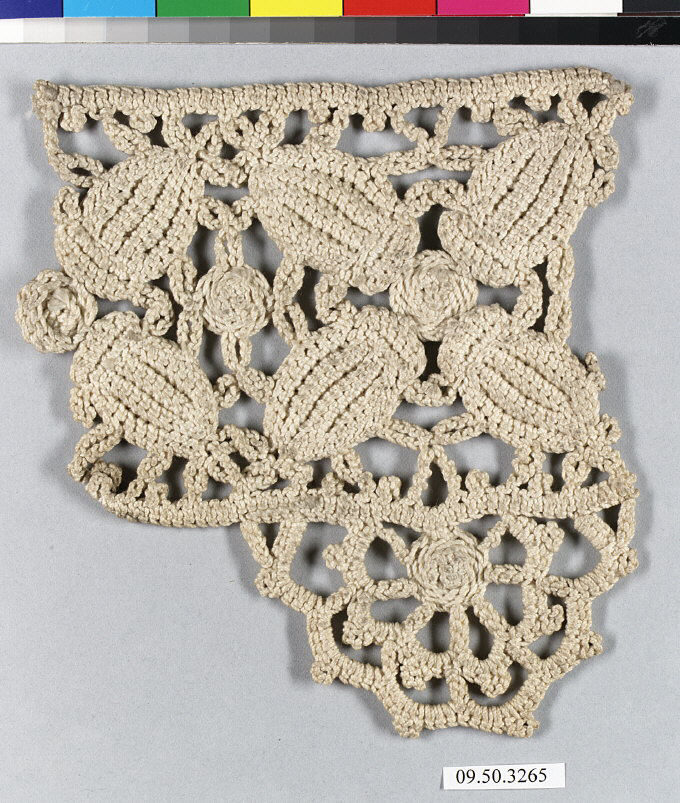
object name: sample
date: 1801-1900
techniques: crochet